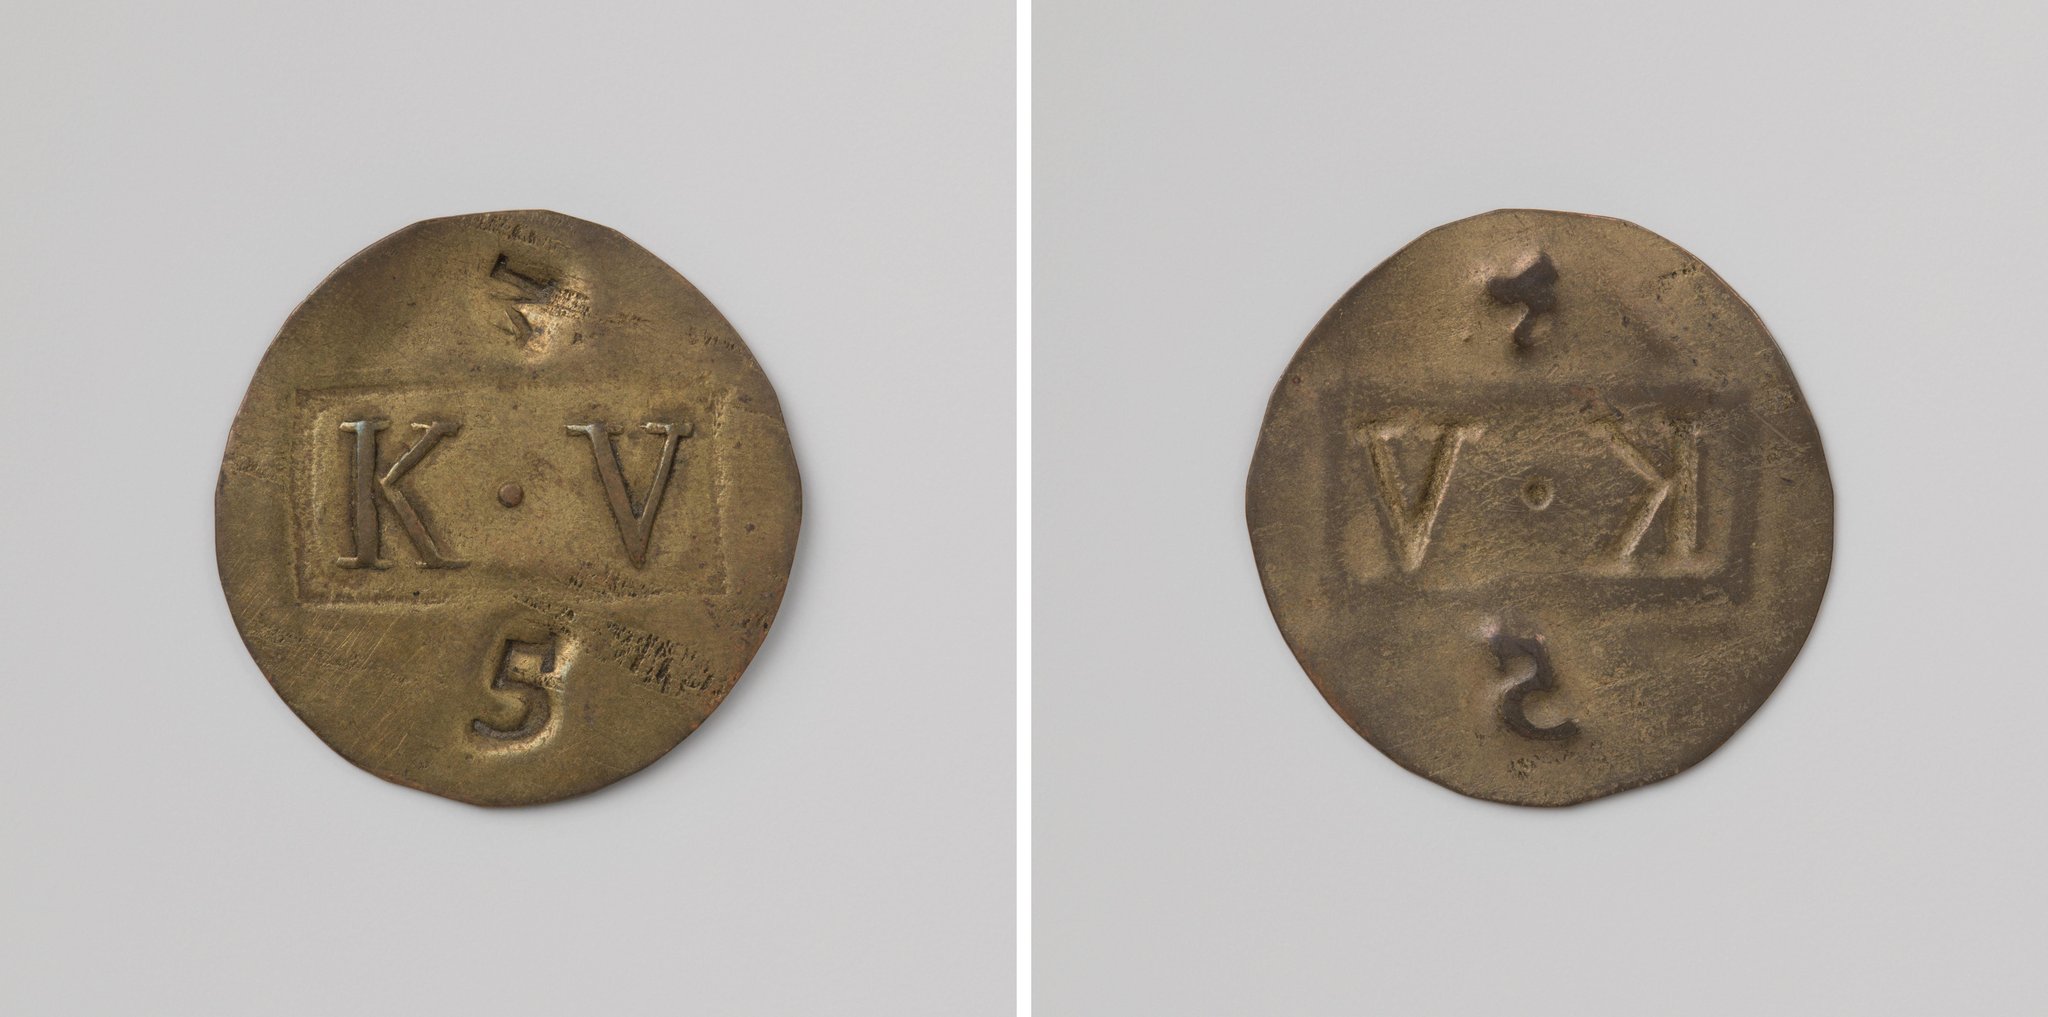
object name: huismunt prison money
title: Kolonie Veenhuizen, huismunt geslagen op last van de Maatschappij van Weldadigheid ter waarde van vijf cent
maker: Anonymous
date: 1818-1859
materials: brass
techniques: striking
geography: netherlands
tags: maatschappij van weldadigheid, veenhuizen